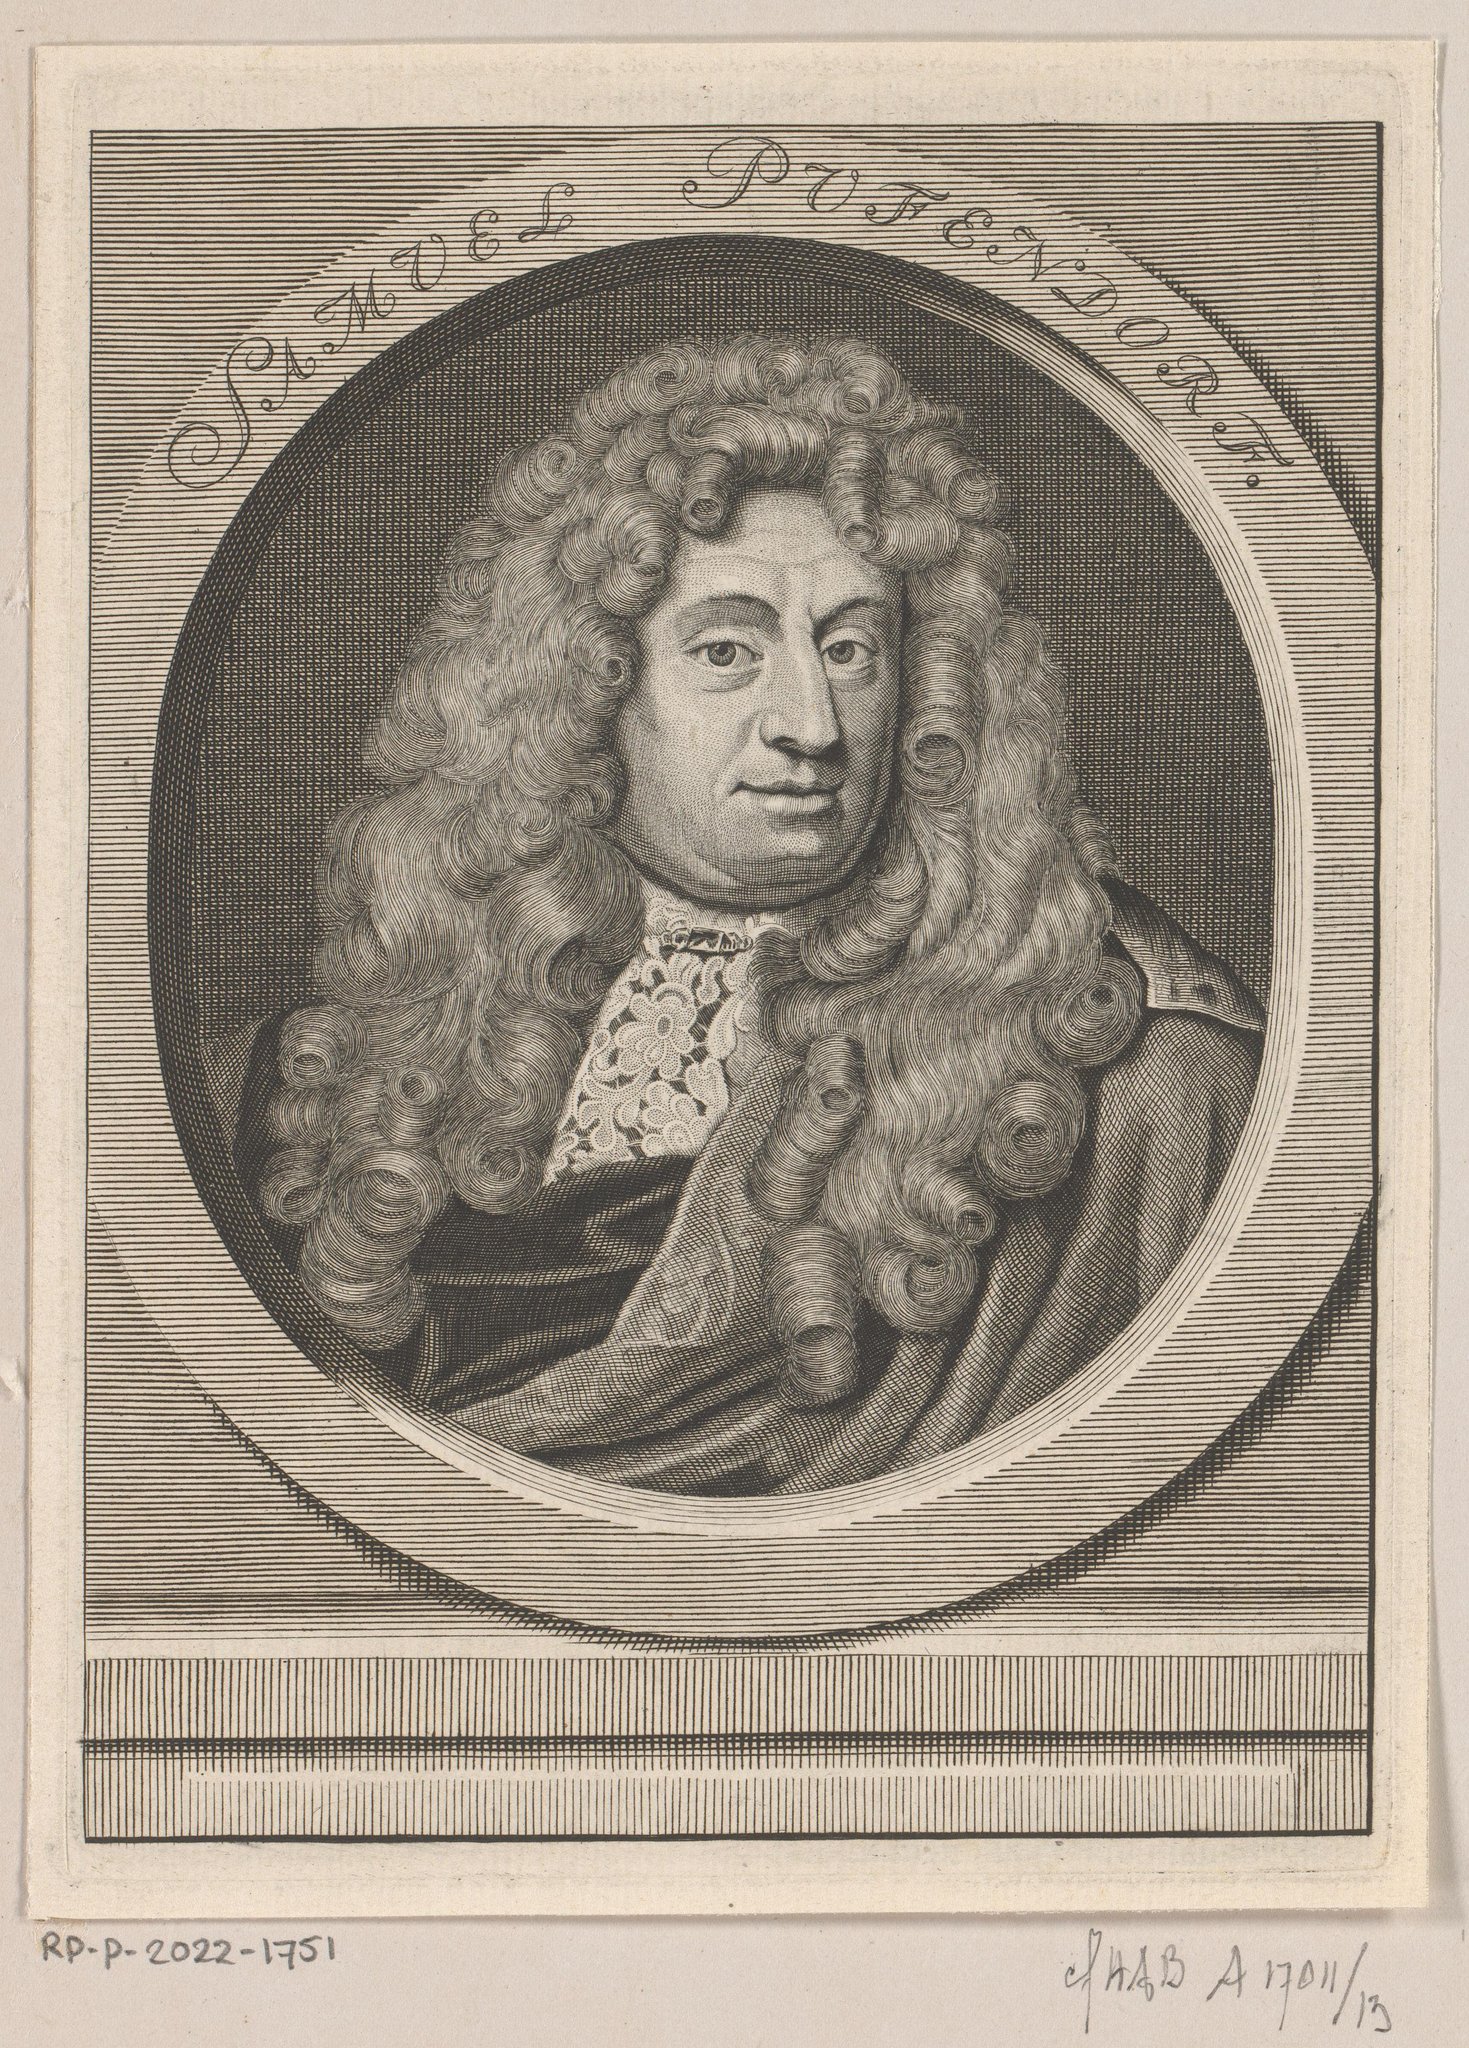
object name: print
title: Portret van Samuel von Pufendorf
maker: Anonymous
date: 1700-1799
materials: paper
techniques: engraving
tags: berlin, history and archaeology (+ portrait of scholar, scientist), scholar, philosopher, historical persons